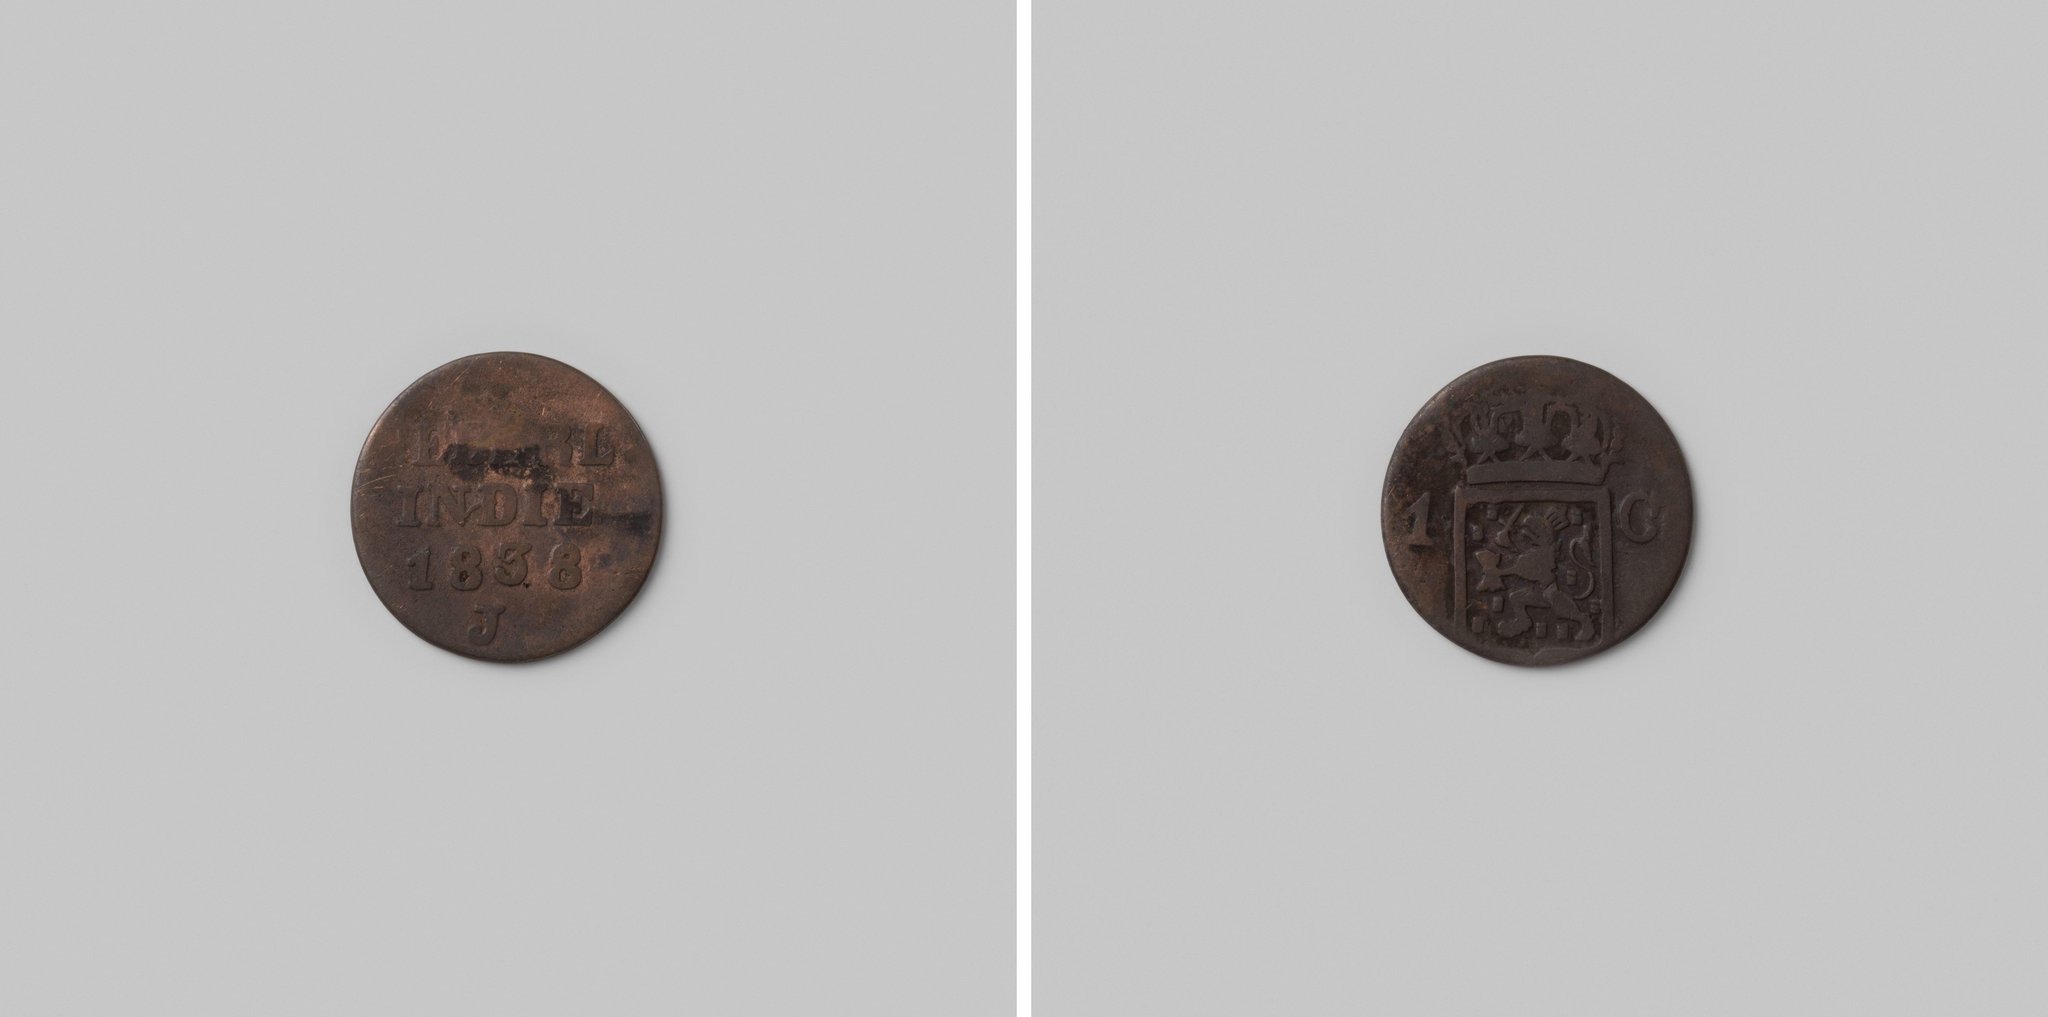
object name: coin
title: Koperen 1 cent muntje uit 1838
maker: Anonymous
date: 1838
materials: copper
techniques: striking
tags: dutch east indies, the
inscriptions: inscription: ‘1 C’, inscription: ‘NEDERL / INDIE / 1838 / J’, inscription: ‘B.A. Seaby, LTD. / Numismatists, / 65, Great Portland Street, / London, W.1’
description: Koperen muntje van 1 cent uit 1838. Voorzijde: opschrift. Keerzijde: gekroond wapen met leeuw erin. Links van het wapen een 1 en rechts van het wapen een C. Het muntje zit in een envelopje met opschrift.